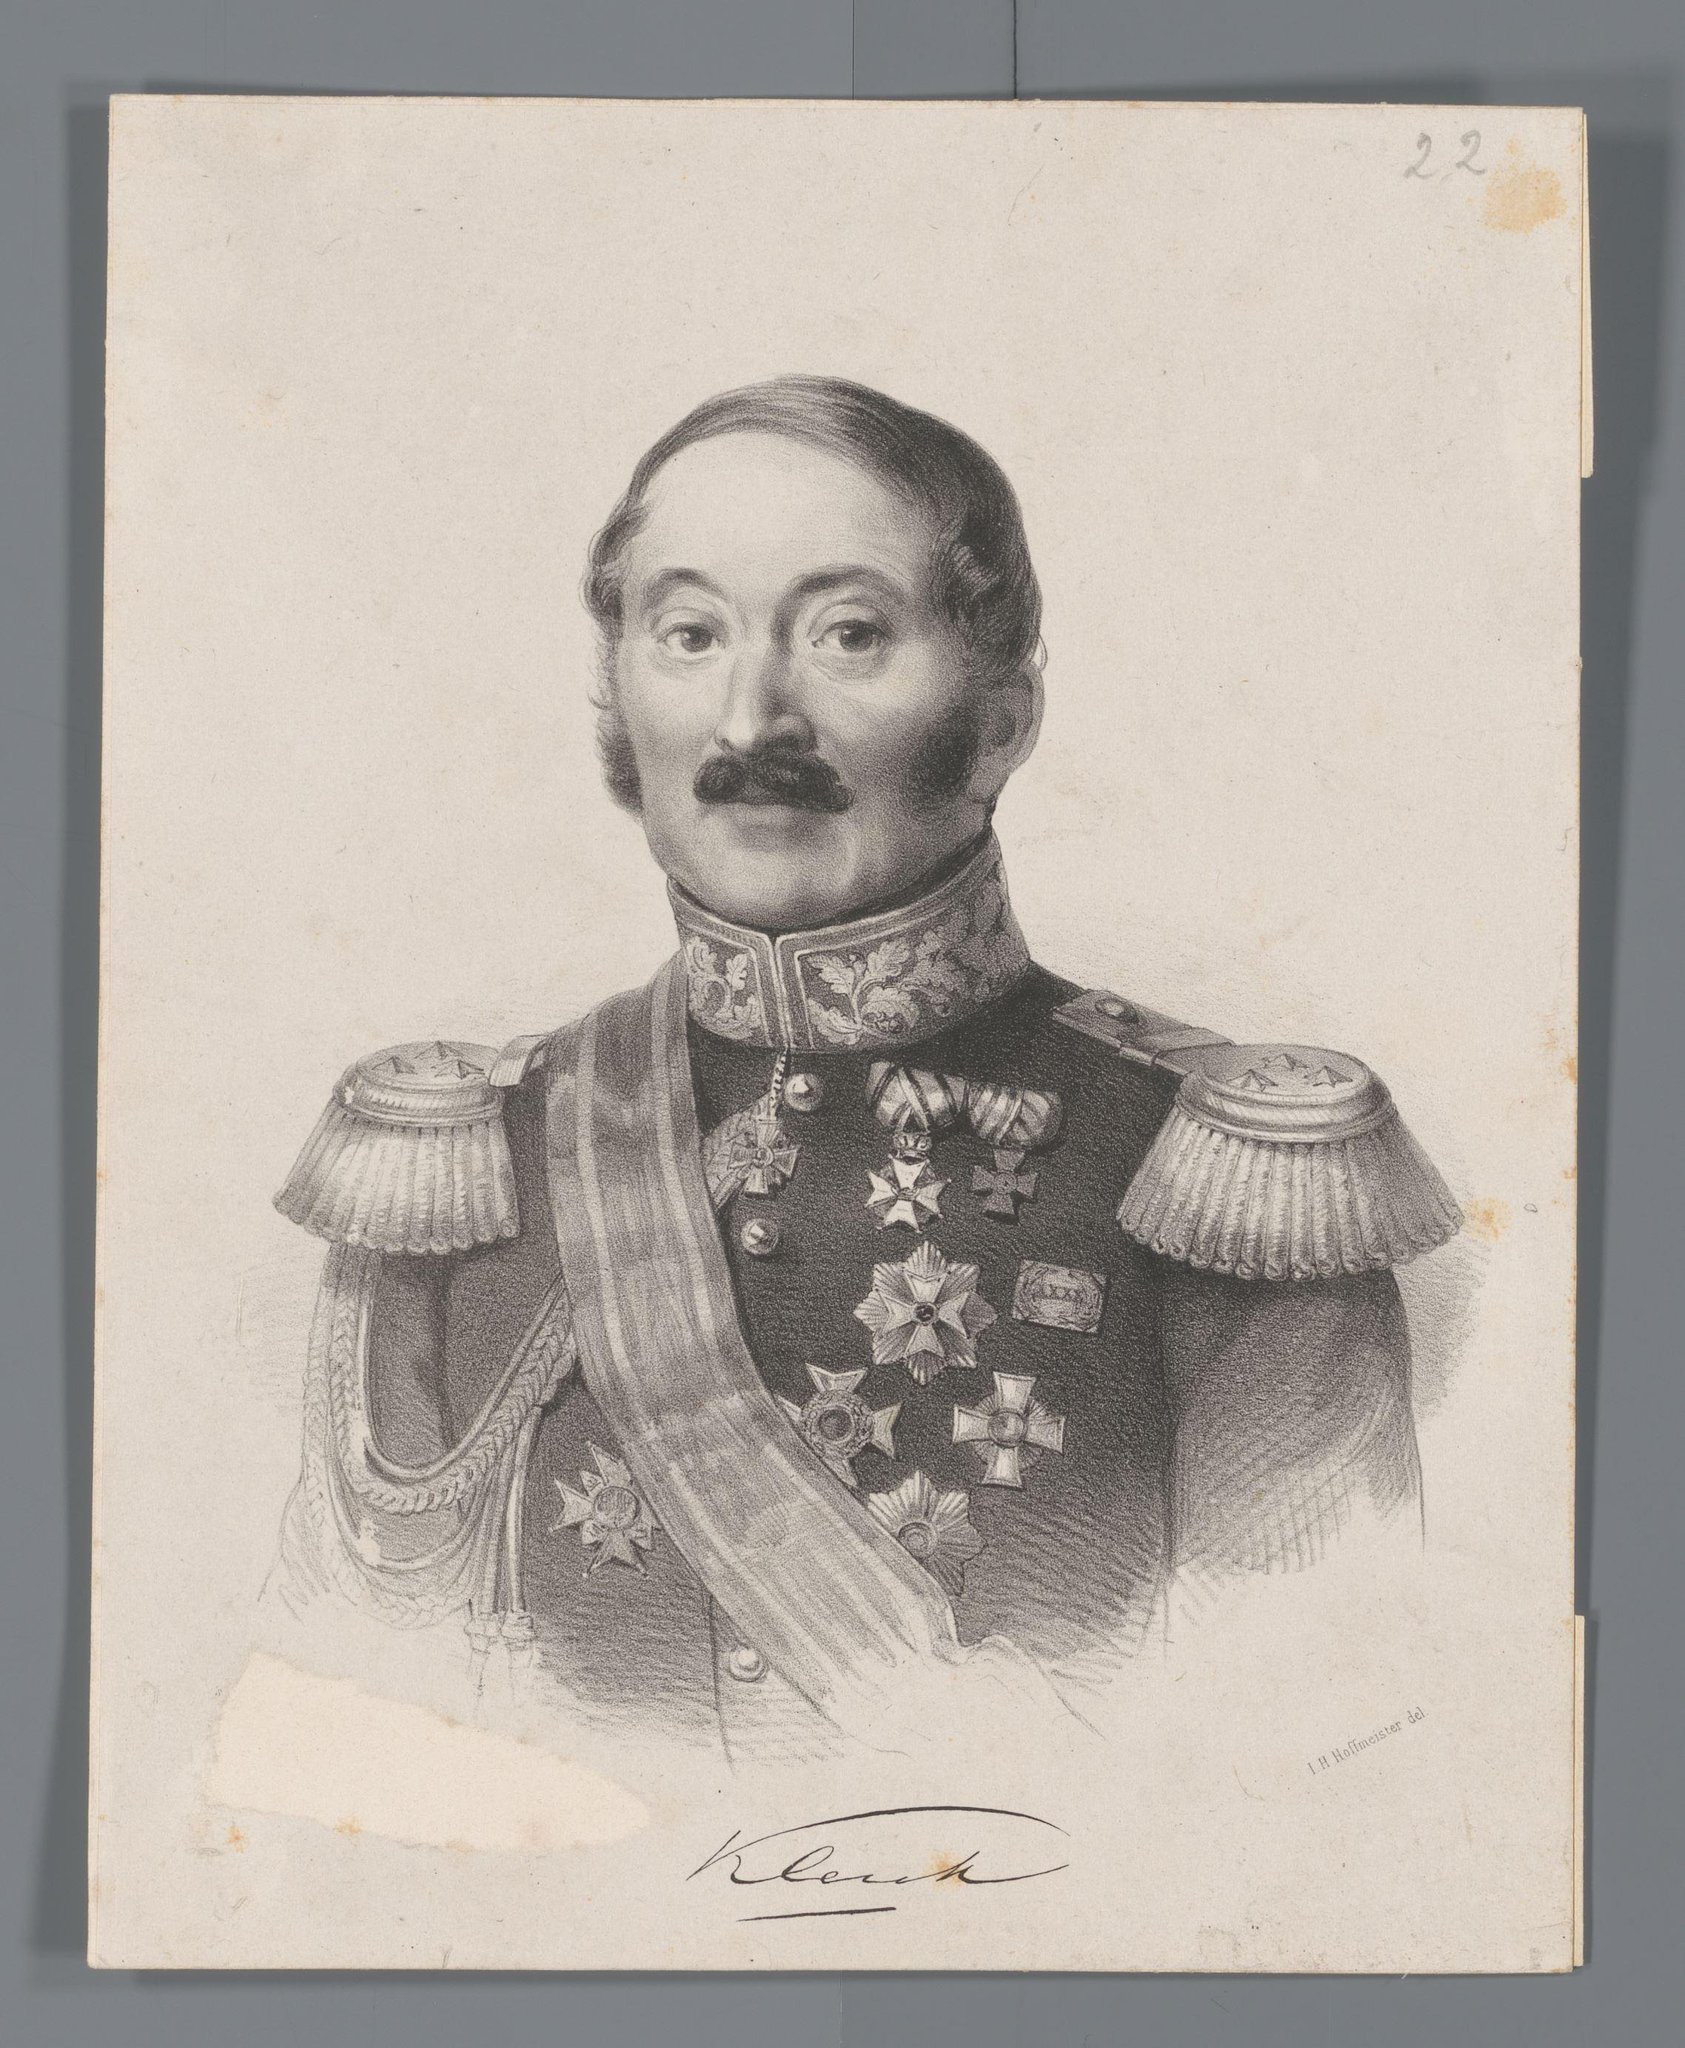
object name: print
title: Portret van Jhr. Rijnholt Antony Klerck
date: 1843-1904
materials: paper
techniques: lithograph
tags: knighthood order, historical persons (+ (full) bust portrait)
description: Portret van Jhr. Rijnholt Antony Klerck, borststuk, met sjerp hangend van rechterschouder en 8 eretekens op de borst. Onder: handtekening. Hoort bij NG-NM-10388-22-B: levensbeschrijving.